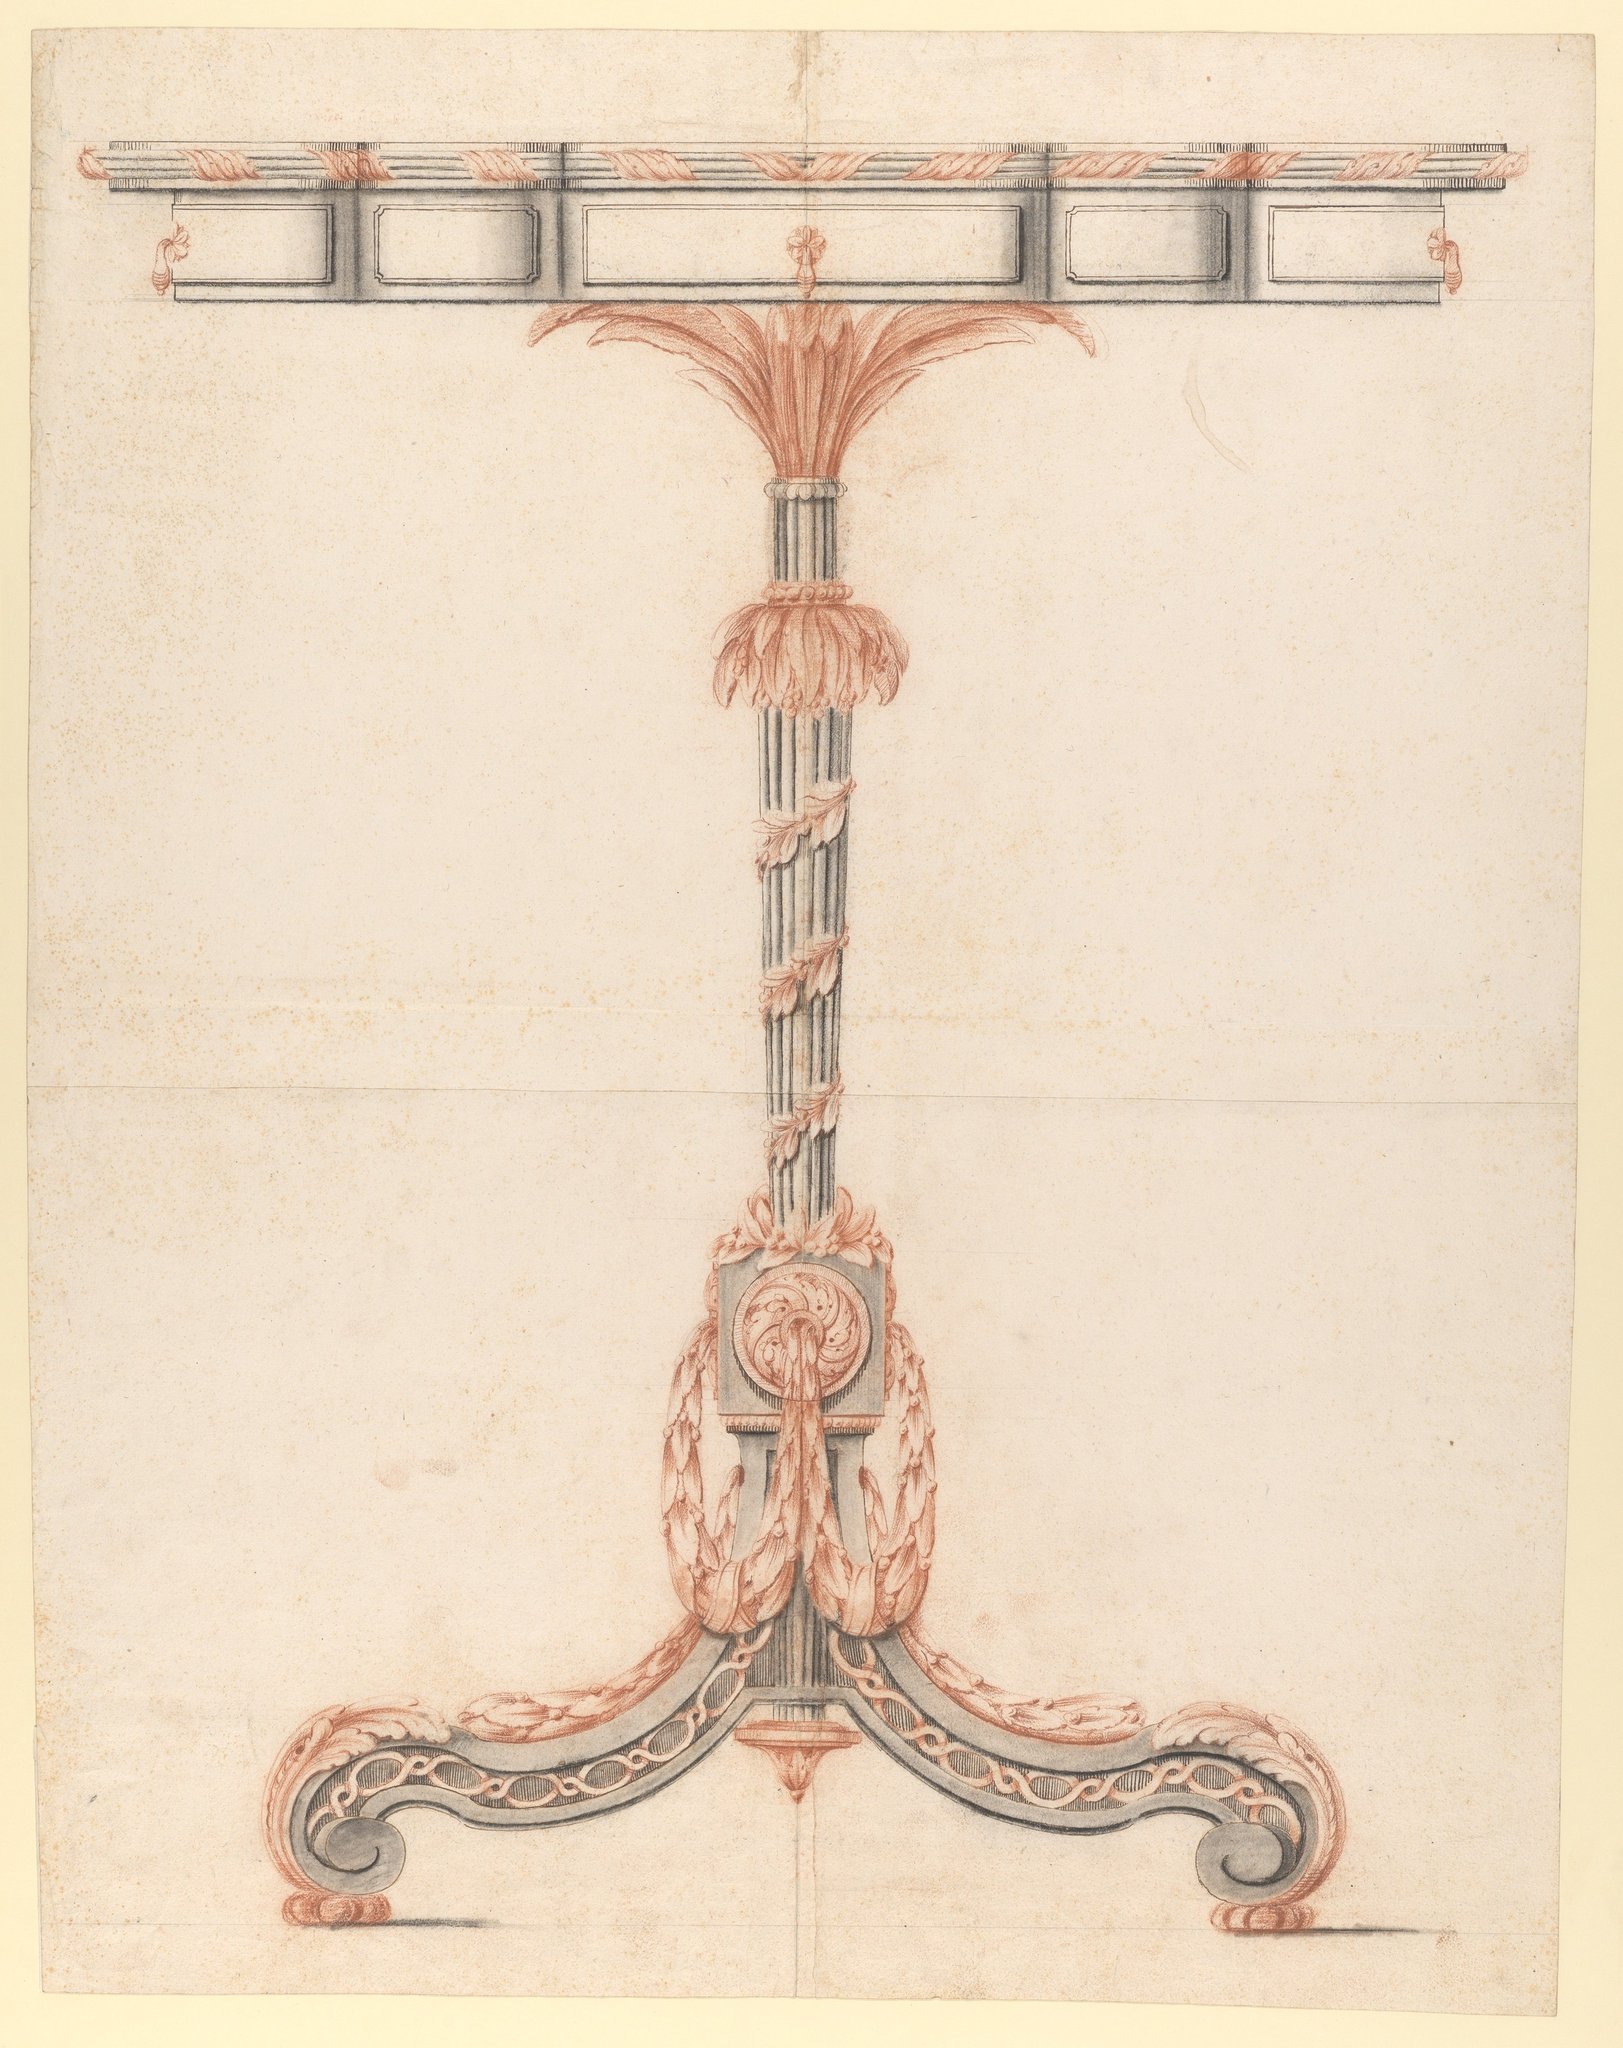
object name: drawing ornament architecture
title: Design for a Silver and Gilt-Bronze Table with a Garland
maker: anonymous, french, 18th century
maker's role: artist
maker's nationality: french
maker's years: 1700-1800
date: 1770-1790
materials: chalk, graphite, ink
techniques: pen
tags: ornament,tables